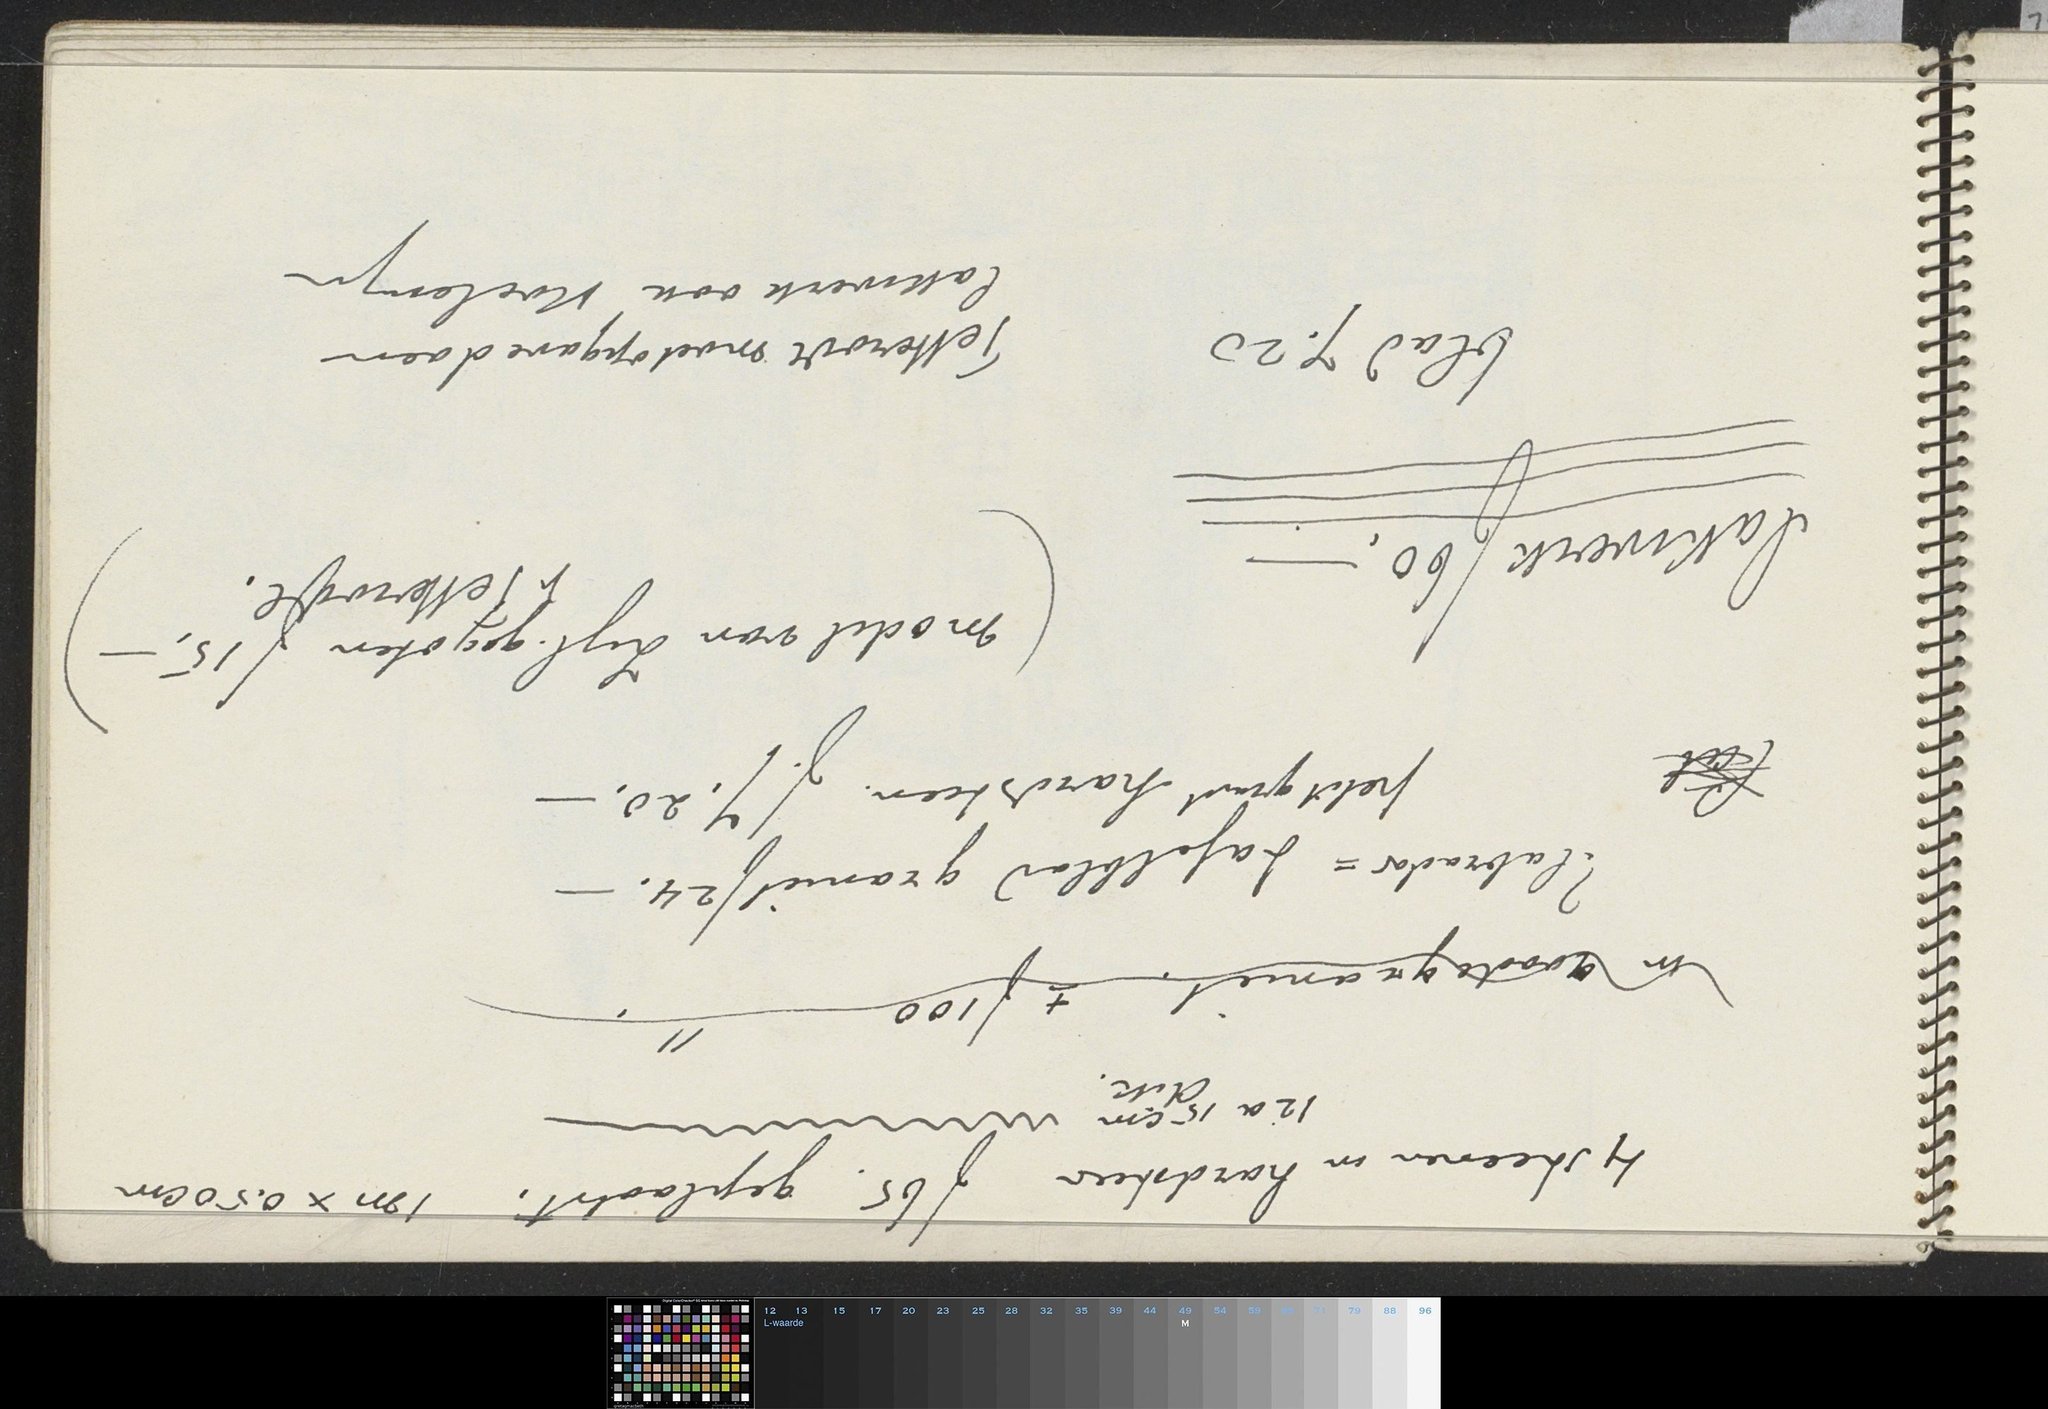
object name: sketchbook leaf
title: Notities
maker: carel adolph lion cachet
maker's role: draughtsman, print maker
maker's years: 1864-1945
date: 1930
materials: ink, paper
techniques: pen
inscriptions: annotation: ‘4 steenen in hardsteen f 65 geplaatst 1 m x 0,50 cm/ 12 a 15 cm/ dik/ ? labrador = tafelblad graniet f 24.-/ pe[...] gra[...]/ hardsteen f. 7.20.-/ model van Zijl gegoten f 15/ Tetterode/ lakwerk f 60/ blad 7.20/ Tetterode moet opgave doen/ lakwerken ook [...]lengen’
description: Blad 9 verso uit een schetsboek met 20 bladen.